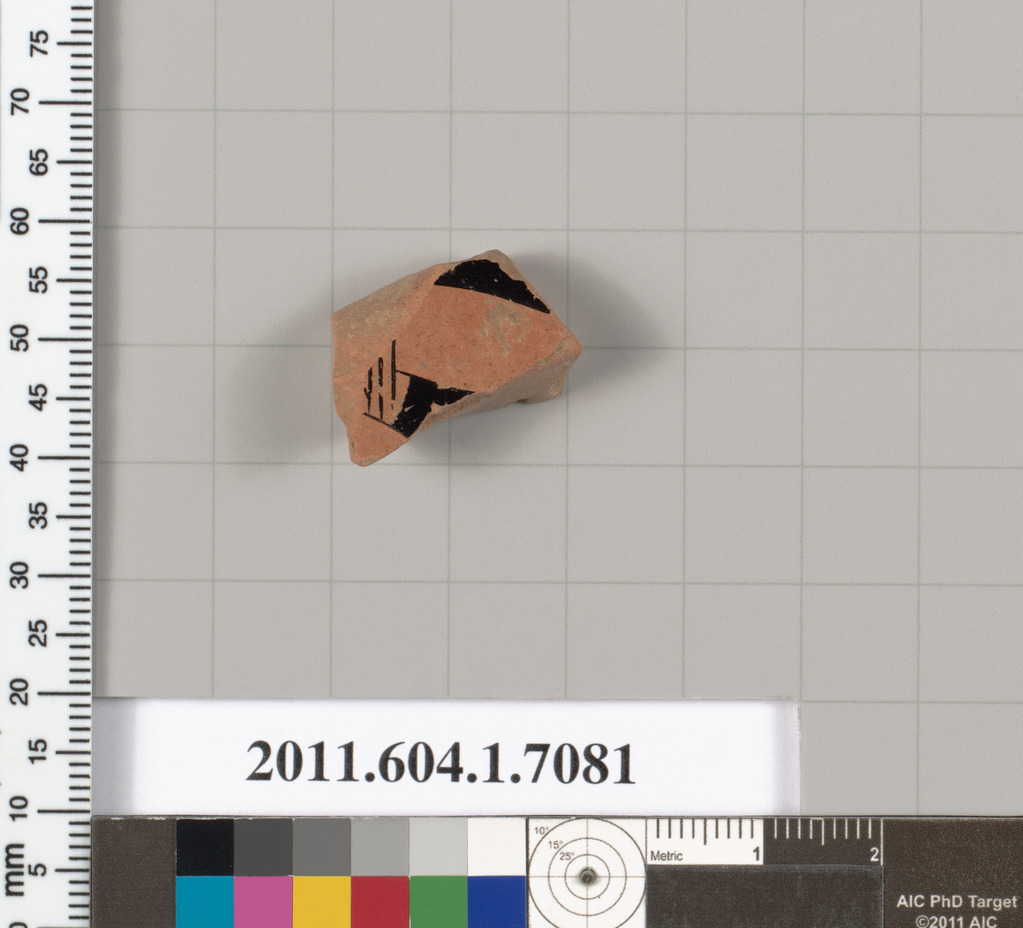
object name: kylix fragment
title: Terracotta fragment of a kylix (drinking cup)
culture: greek, attic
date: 500-480 BCE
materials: terracotta